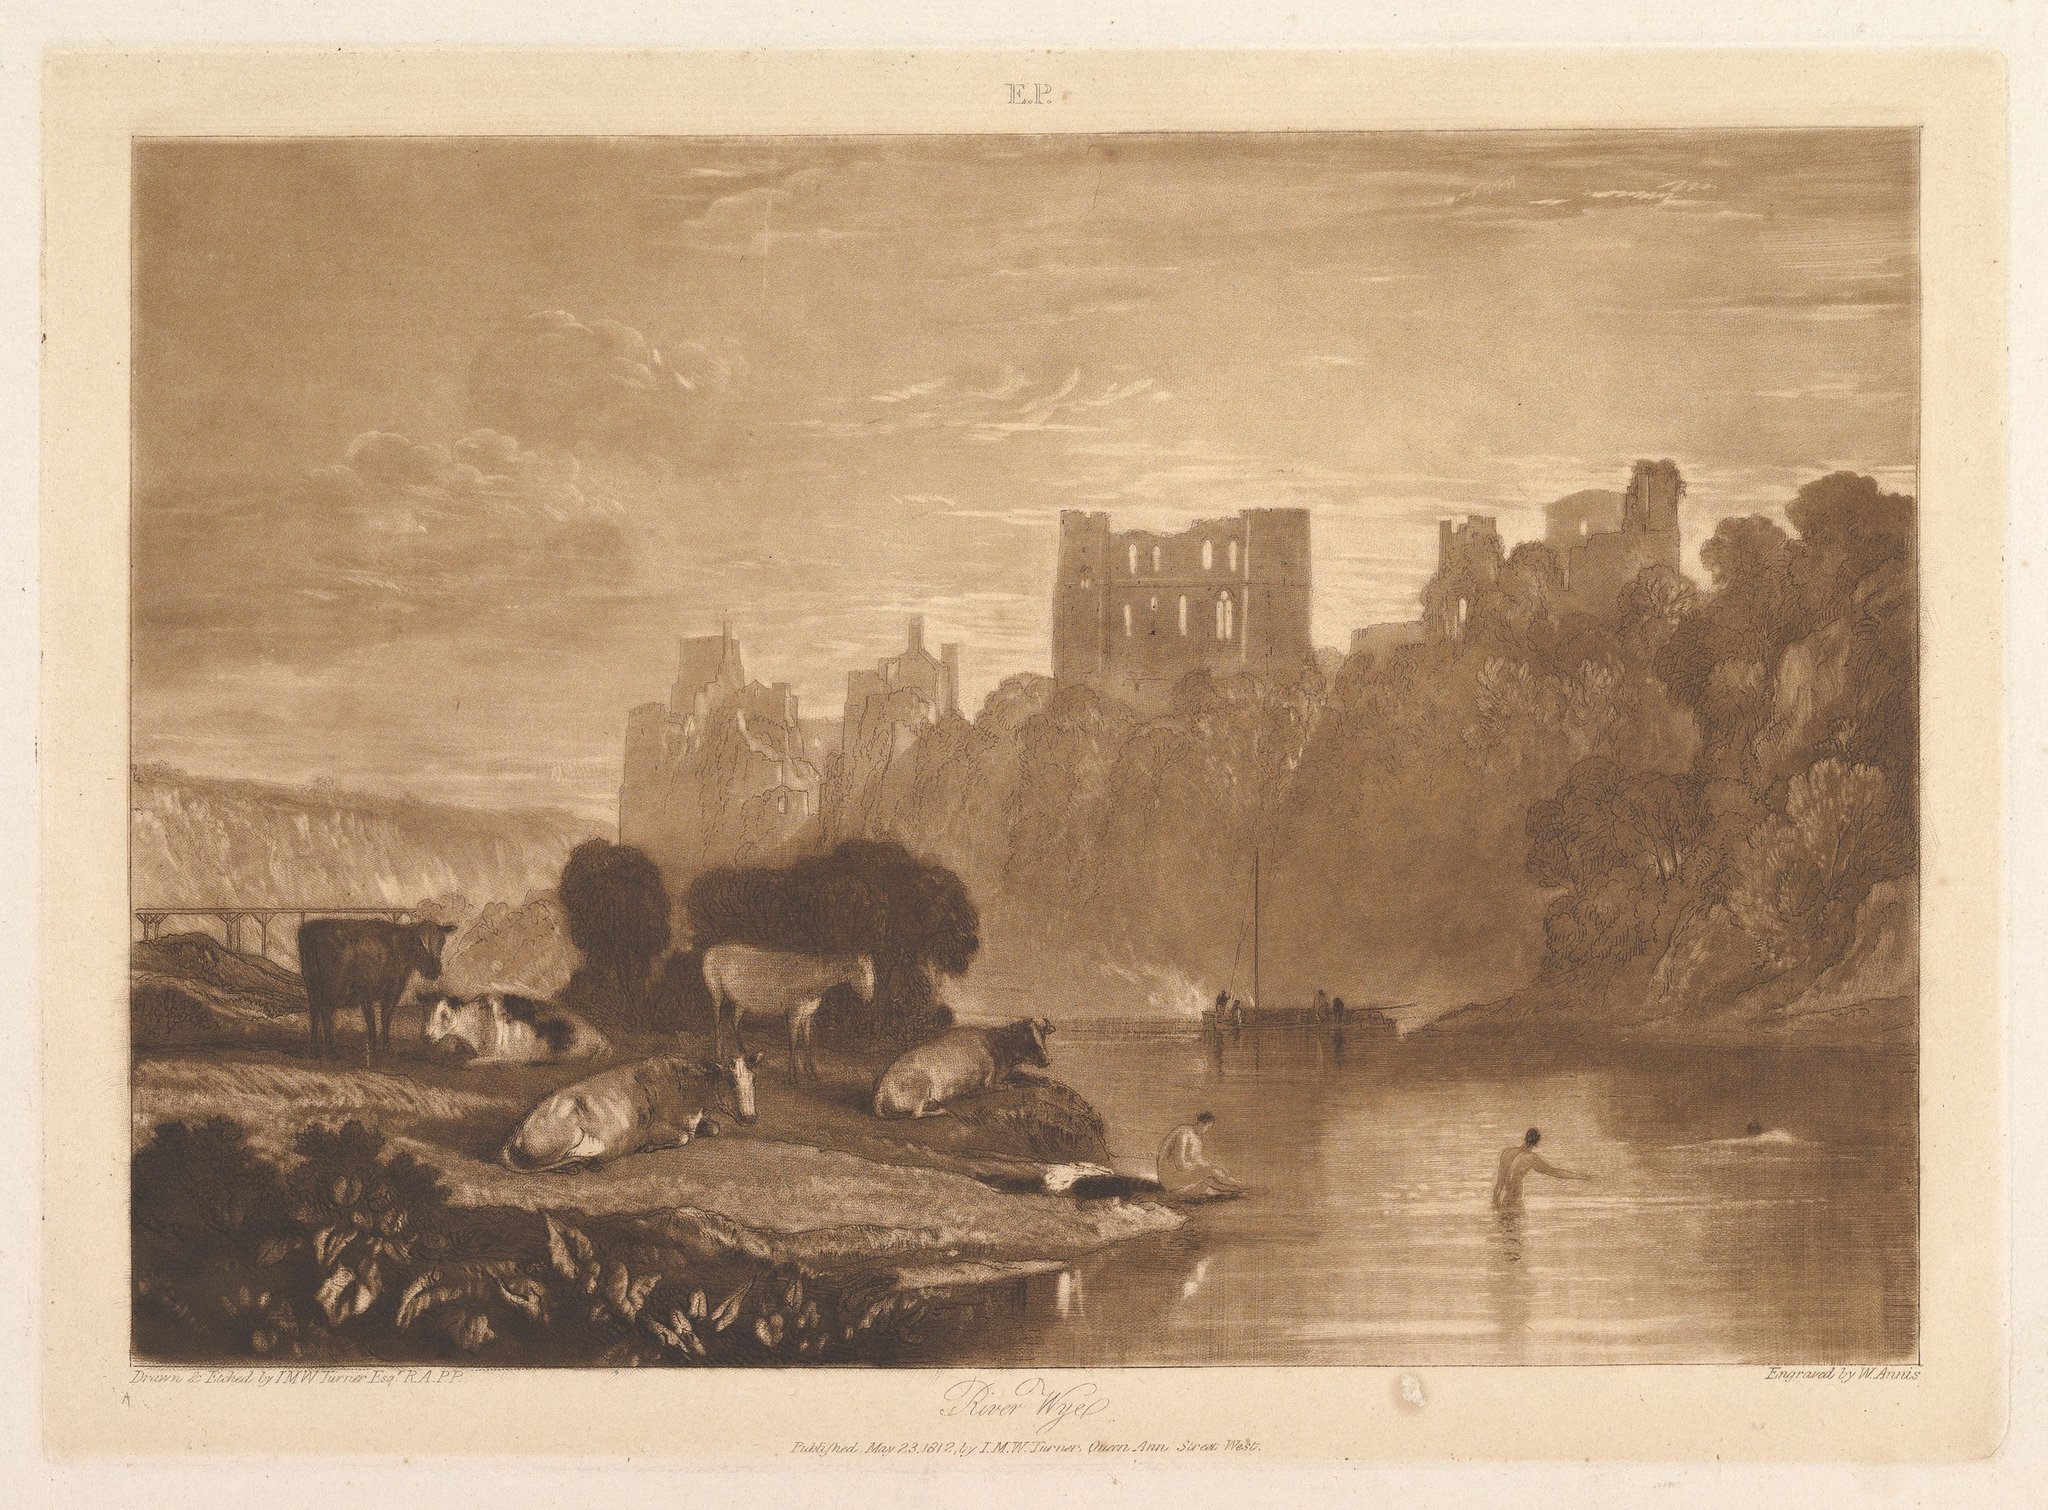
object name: print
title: River Wye (Liber Studiorum, part X, plate 48)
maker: joseph mallord william turner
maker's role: artist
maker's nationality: british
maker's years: 1775-1851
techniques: etching, mezzotint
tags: men,cows,goats,rivers,bathing